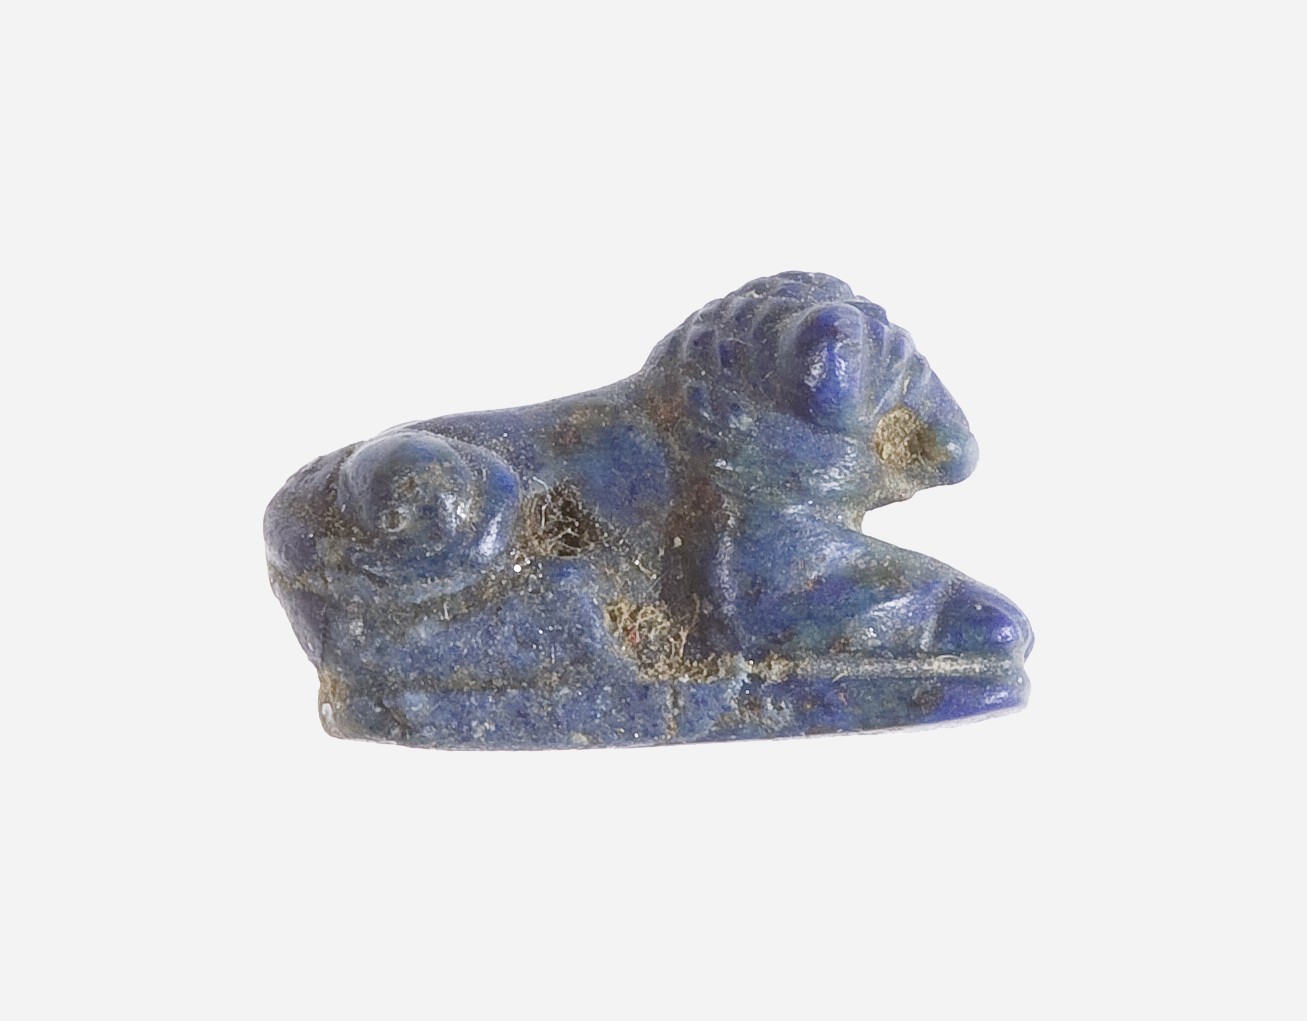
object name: amulet, lion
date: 1550-1295 BCE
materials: lapis lazuli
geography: egypt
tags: lions